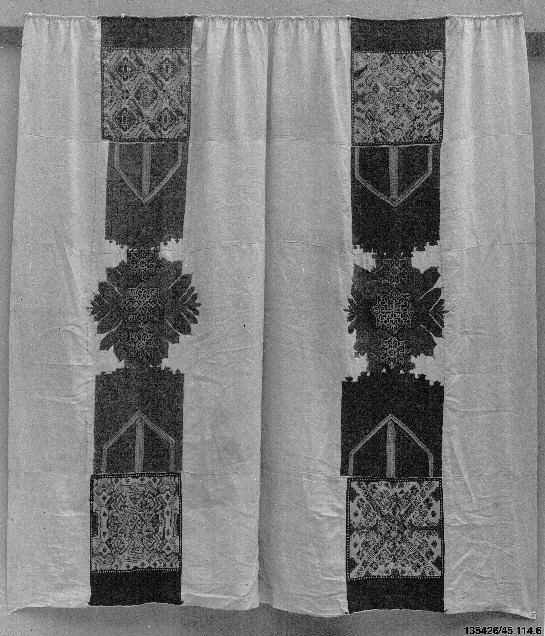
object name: hanging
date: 1701-1800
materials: linen, silk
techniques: embroidery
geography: morocco